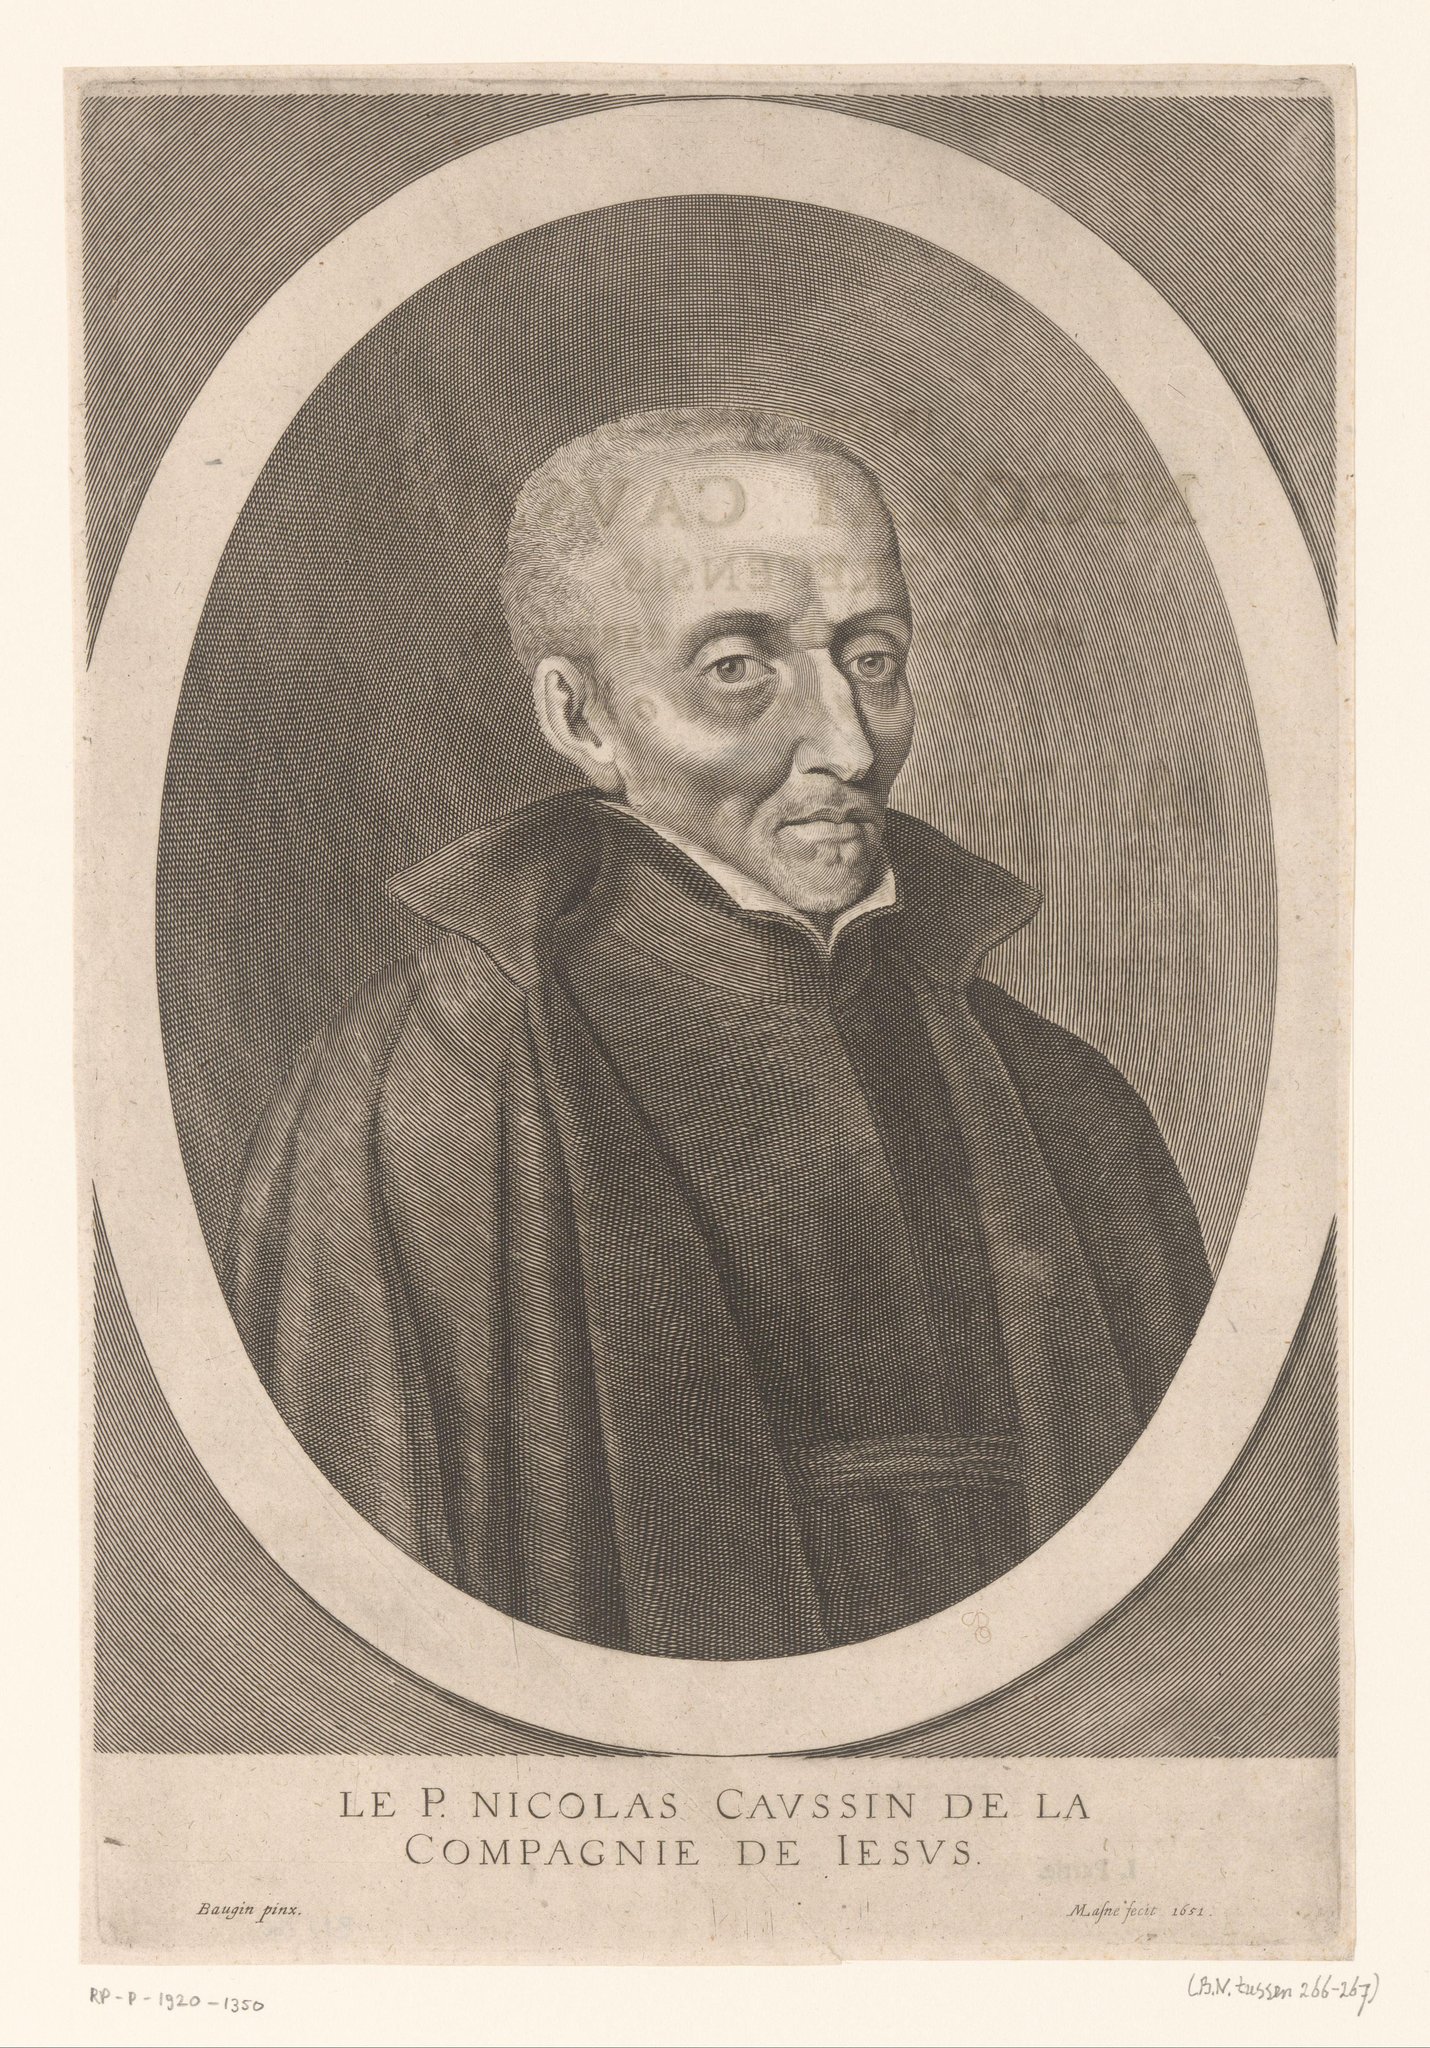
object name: print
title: Portret van Nicolas Caussin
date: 1651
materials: paper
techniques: engraving, letterpress printing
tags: priest, historical persons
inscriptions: collector's mark: Lugt 2228